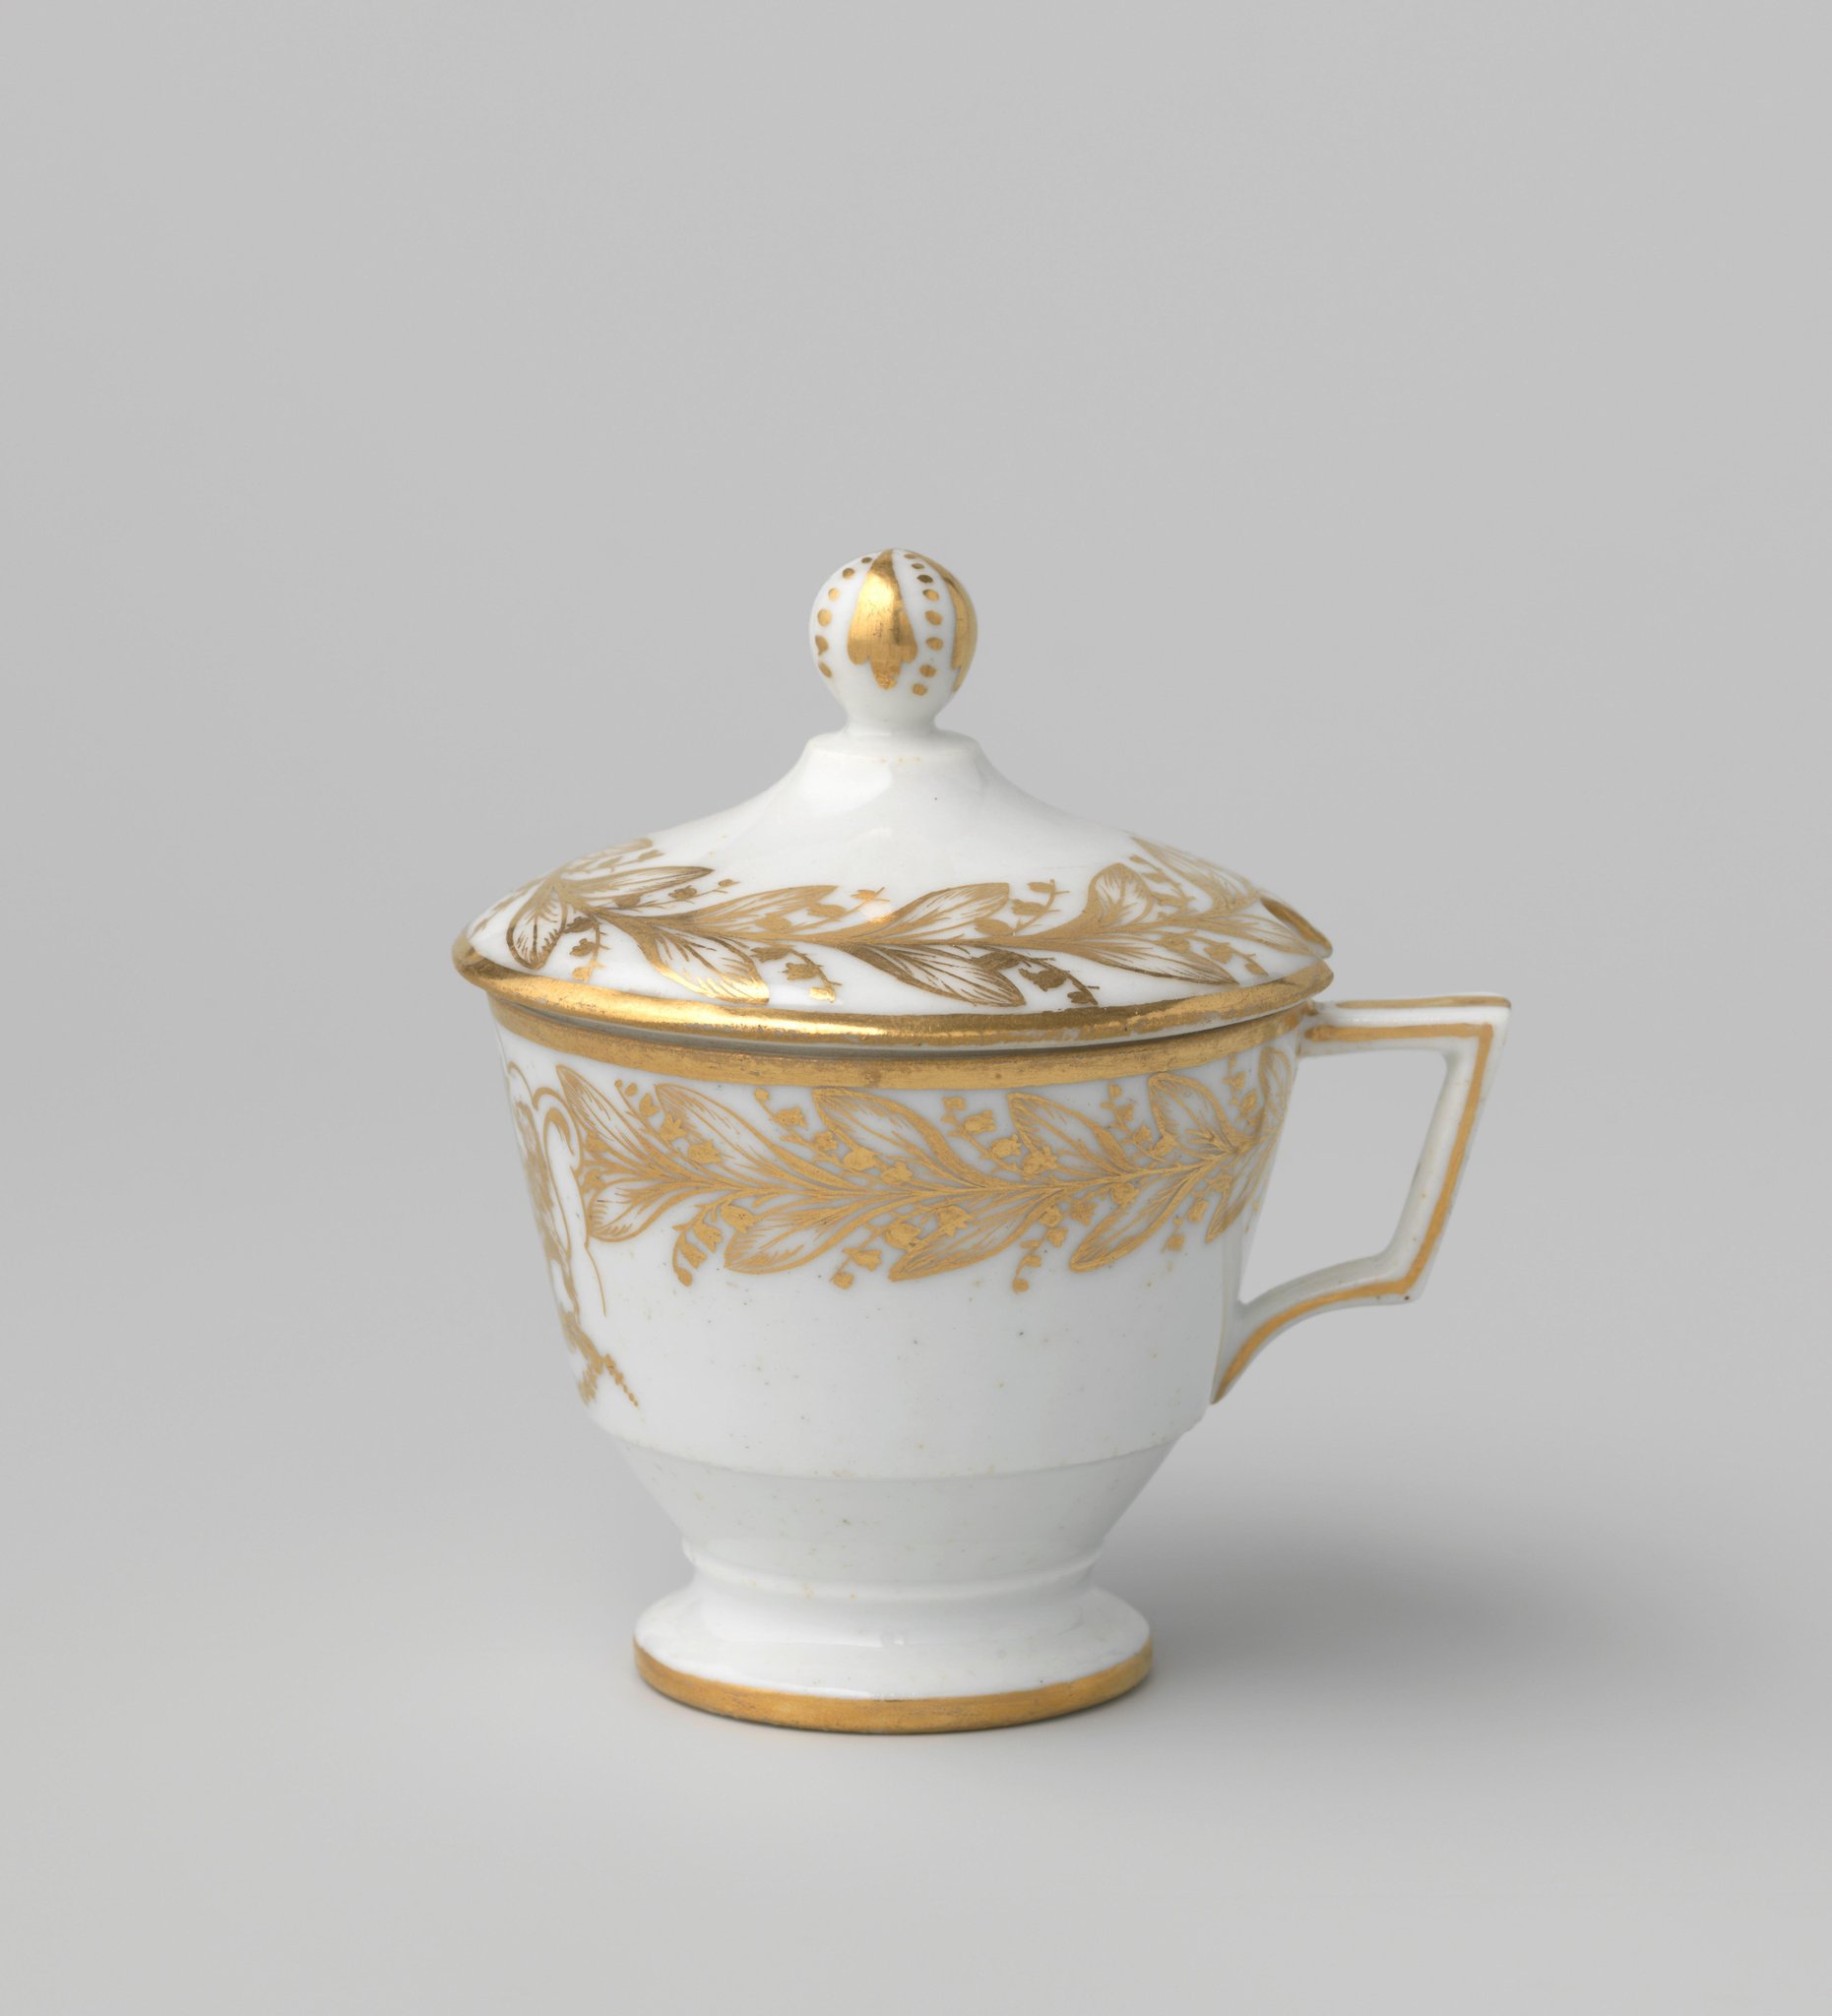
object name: mustard pot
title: Mustard pot with the coat of arms of Hendrik Peter Godfried Quack and Isabella Gertraud von Carnap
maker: Anonymous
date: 1790-1800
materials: glaze, gold, paint, porcelain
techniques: firing, forming, gilding, turning, vitrification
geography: paris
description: Mosterpot van porselein op hoge voet en met een hoekig oor, beschilderd op het glazuur met goud. Op de buitenwand het alliantiewapen van Hendrik Peter Godfried Quack en Isabella Gertraud von Carnap en een bloemrank. Gouden band op de rand en de voet. De deksel met een bloemrank en ronde dekselknop. In de rand van de deksel zit een uitsparing voor een lepel.